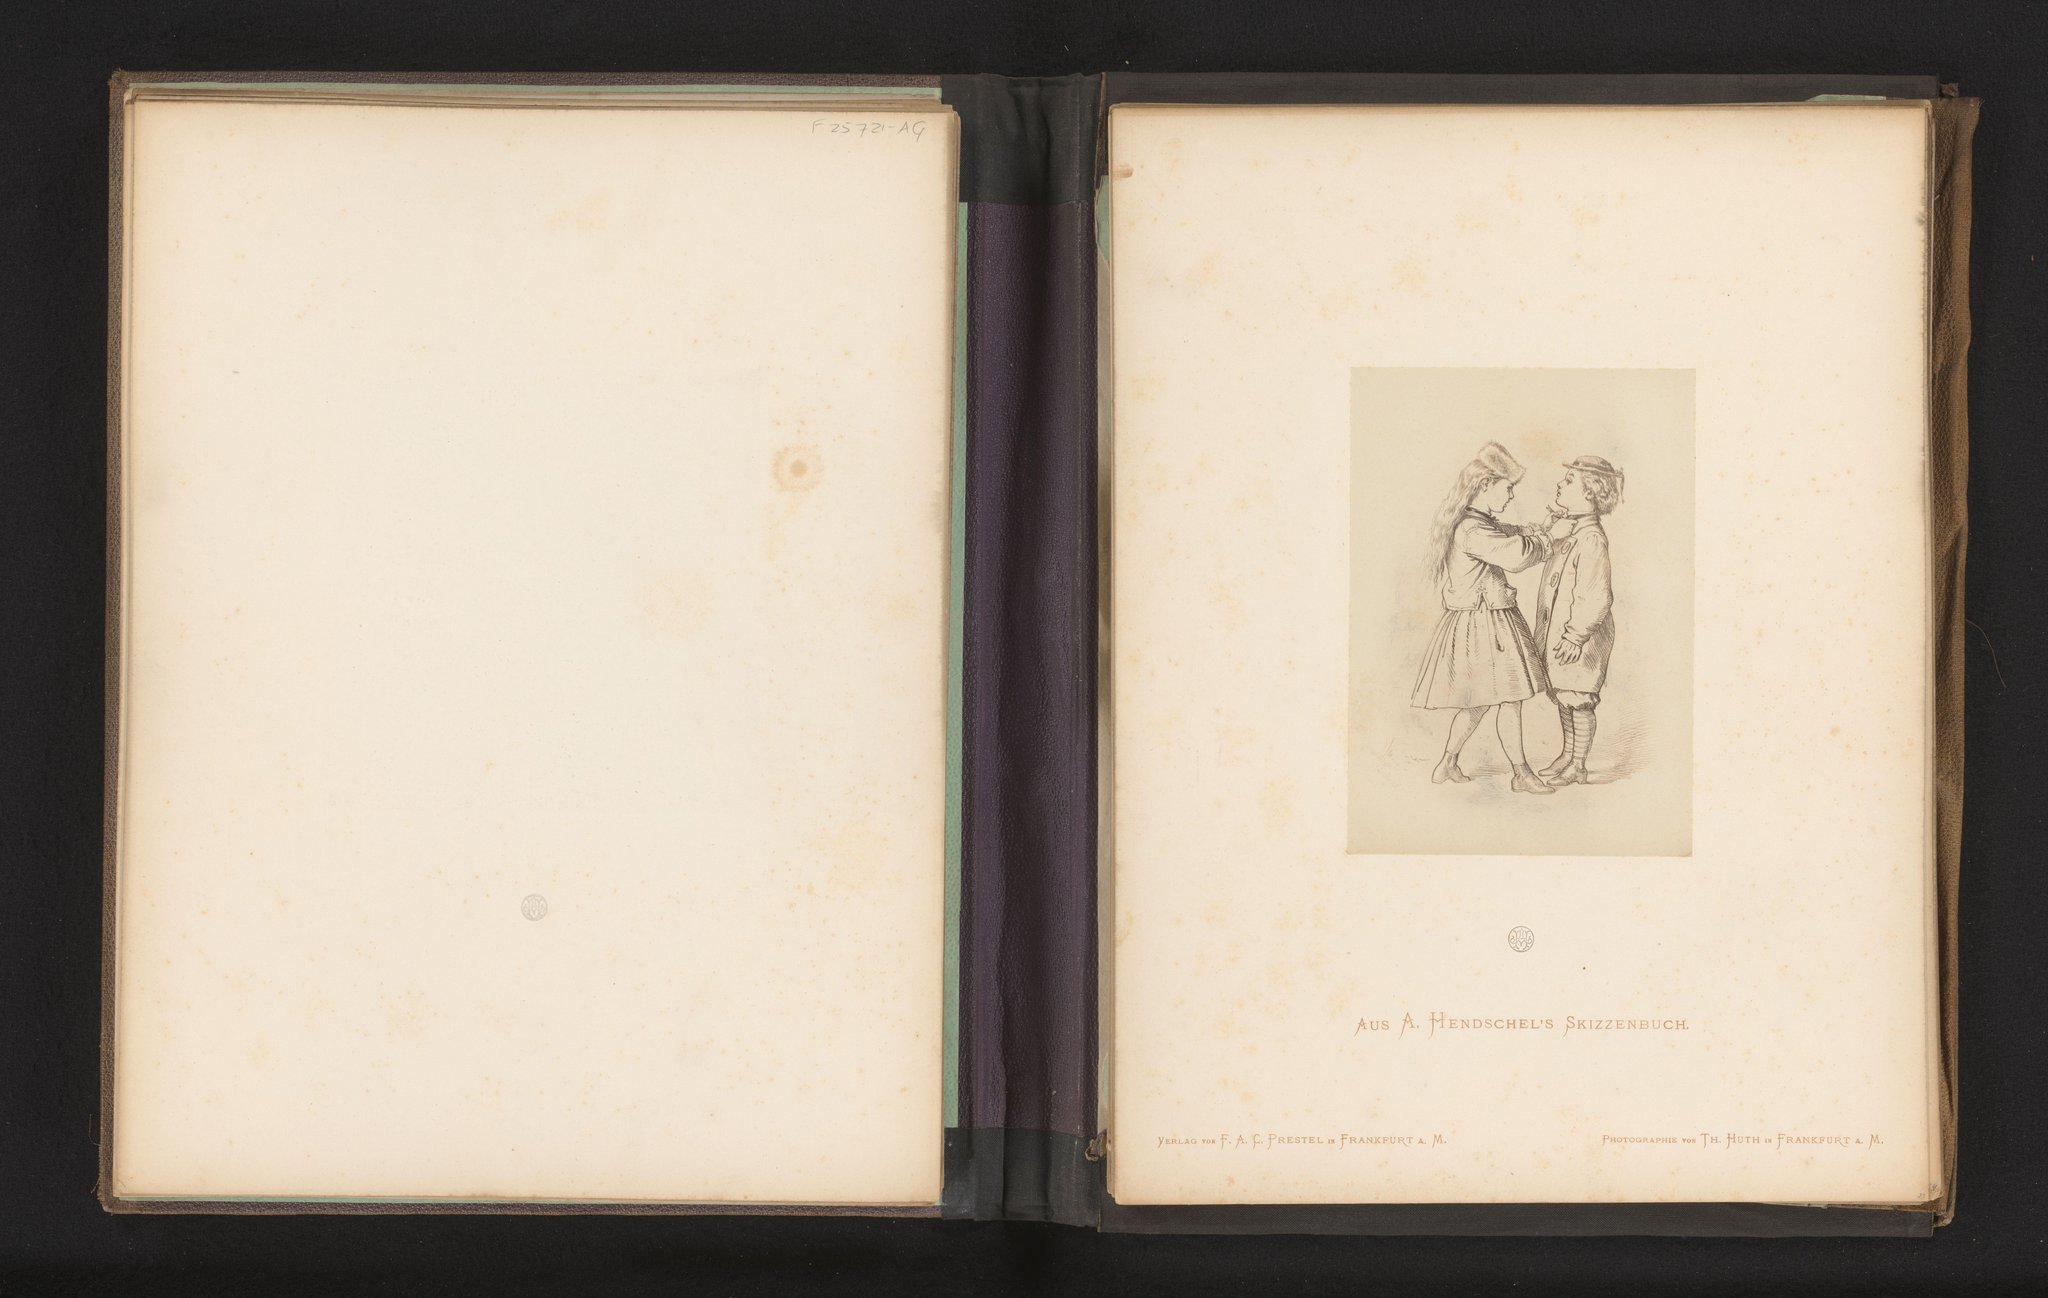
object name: photograph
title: Fotoreproductie van een schets van twee kinderen door Albert Hendschel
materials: paper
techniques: albumen print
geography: frankfurt am main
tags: child (+ two persons)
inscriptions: monogram: ‘AH’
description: Deze foto maakt deel uit van een omslag met 50 foto's op 48 bladen, een lijst van afbeeldingen en een titelblad.